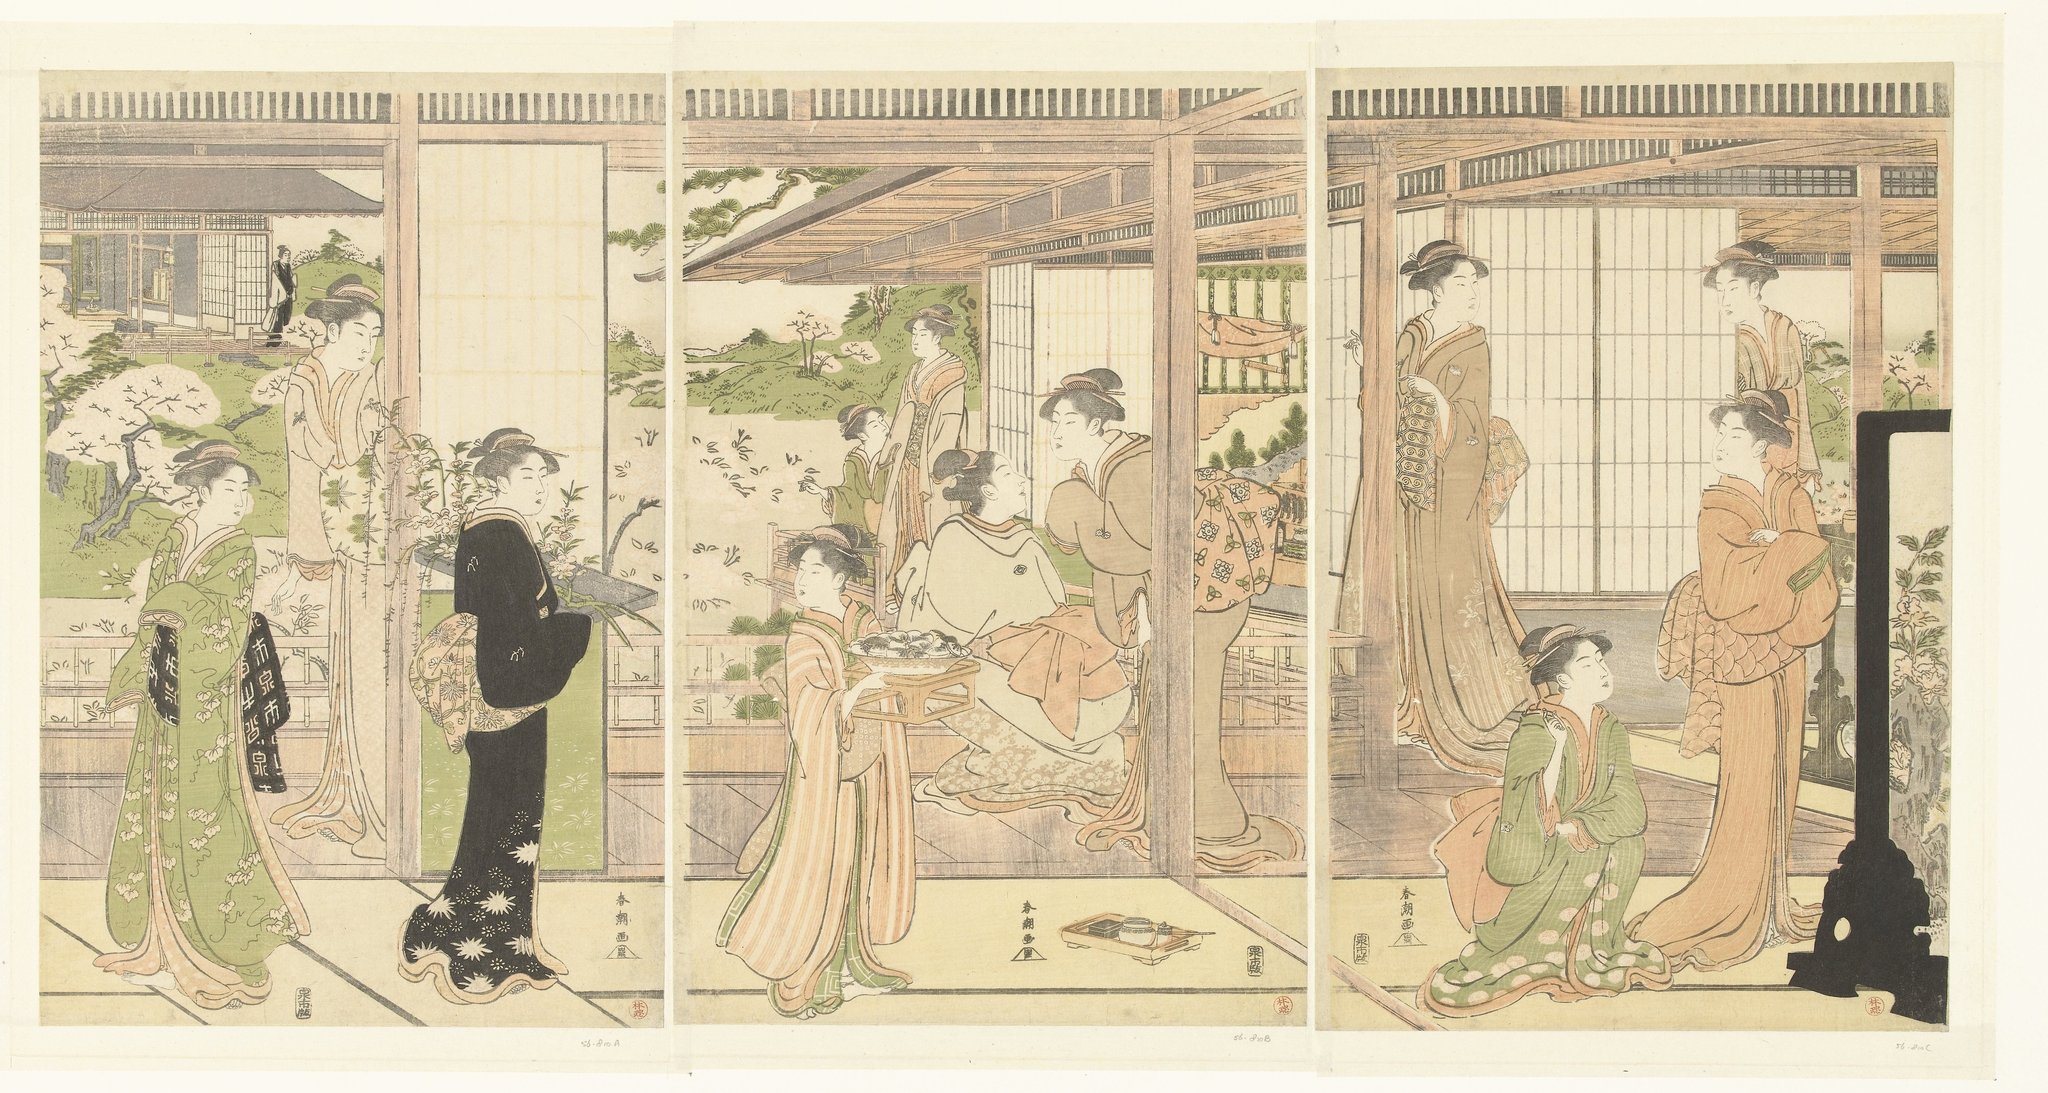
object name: print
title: Voorbereidingen voor het poppenfeest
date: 1785-1800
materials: paper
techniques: woodcut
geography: tokyo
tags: festivities, puppet and marionette show, trees (+ flowers, blossom, blossoming)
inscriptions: collector's mark: Lugt 2971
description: Verschillende vrouwen, in de kamers van een groot huis, voorbereidingen treffend voor het poppenfestival; door opengeschoven deuren een gezicht op de tuin met bloeiende bomen.